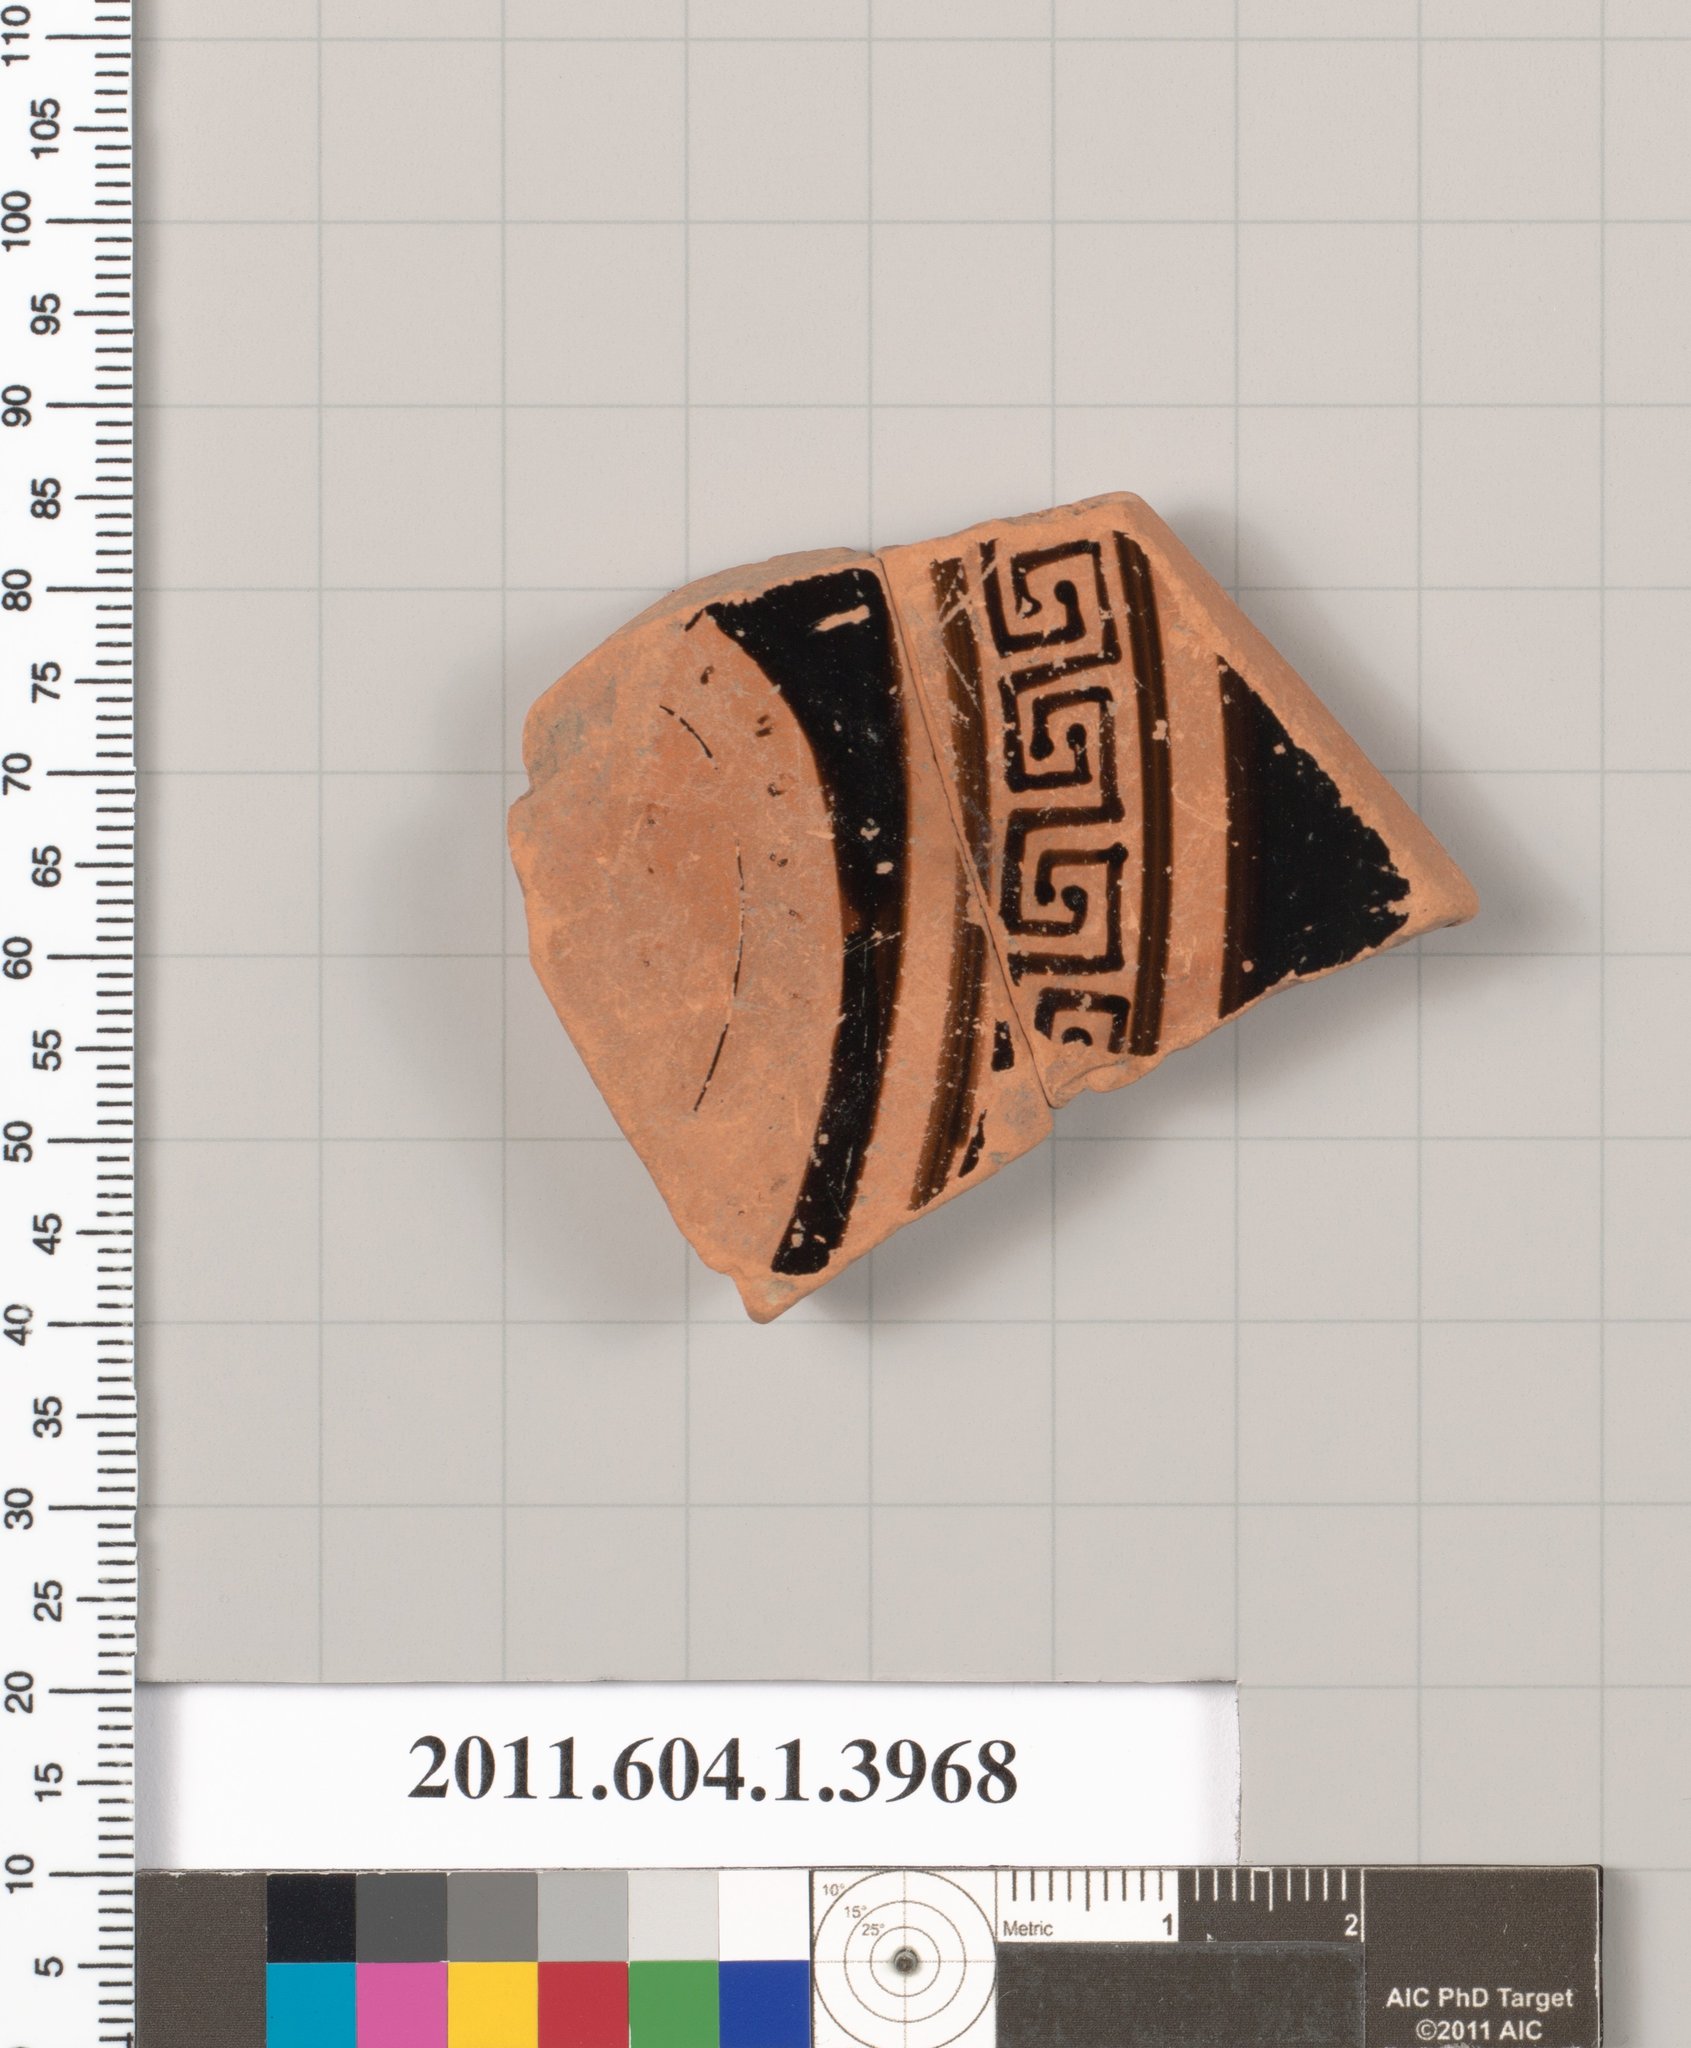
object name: kylix fragment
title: Terracotta fragment of a kylix (drinking cup)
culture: greek, attic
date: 475-451 BCE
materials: terracotta